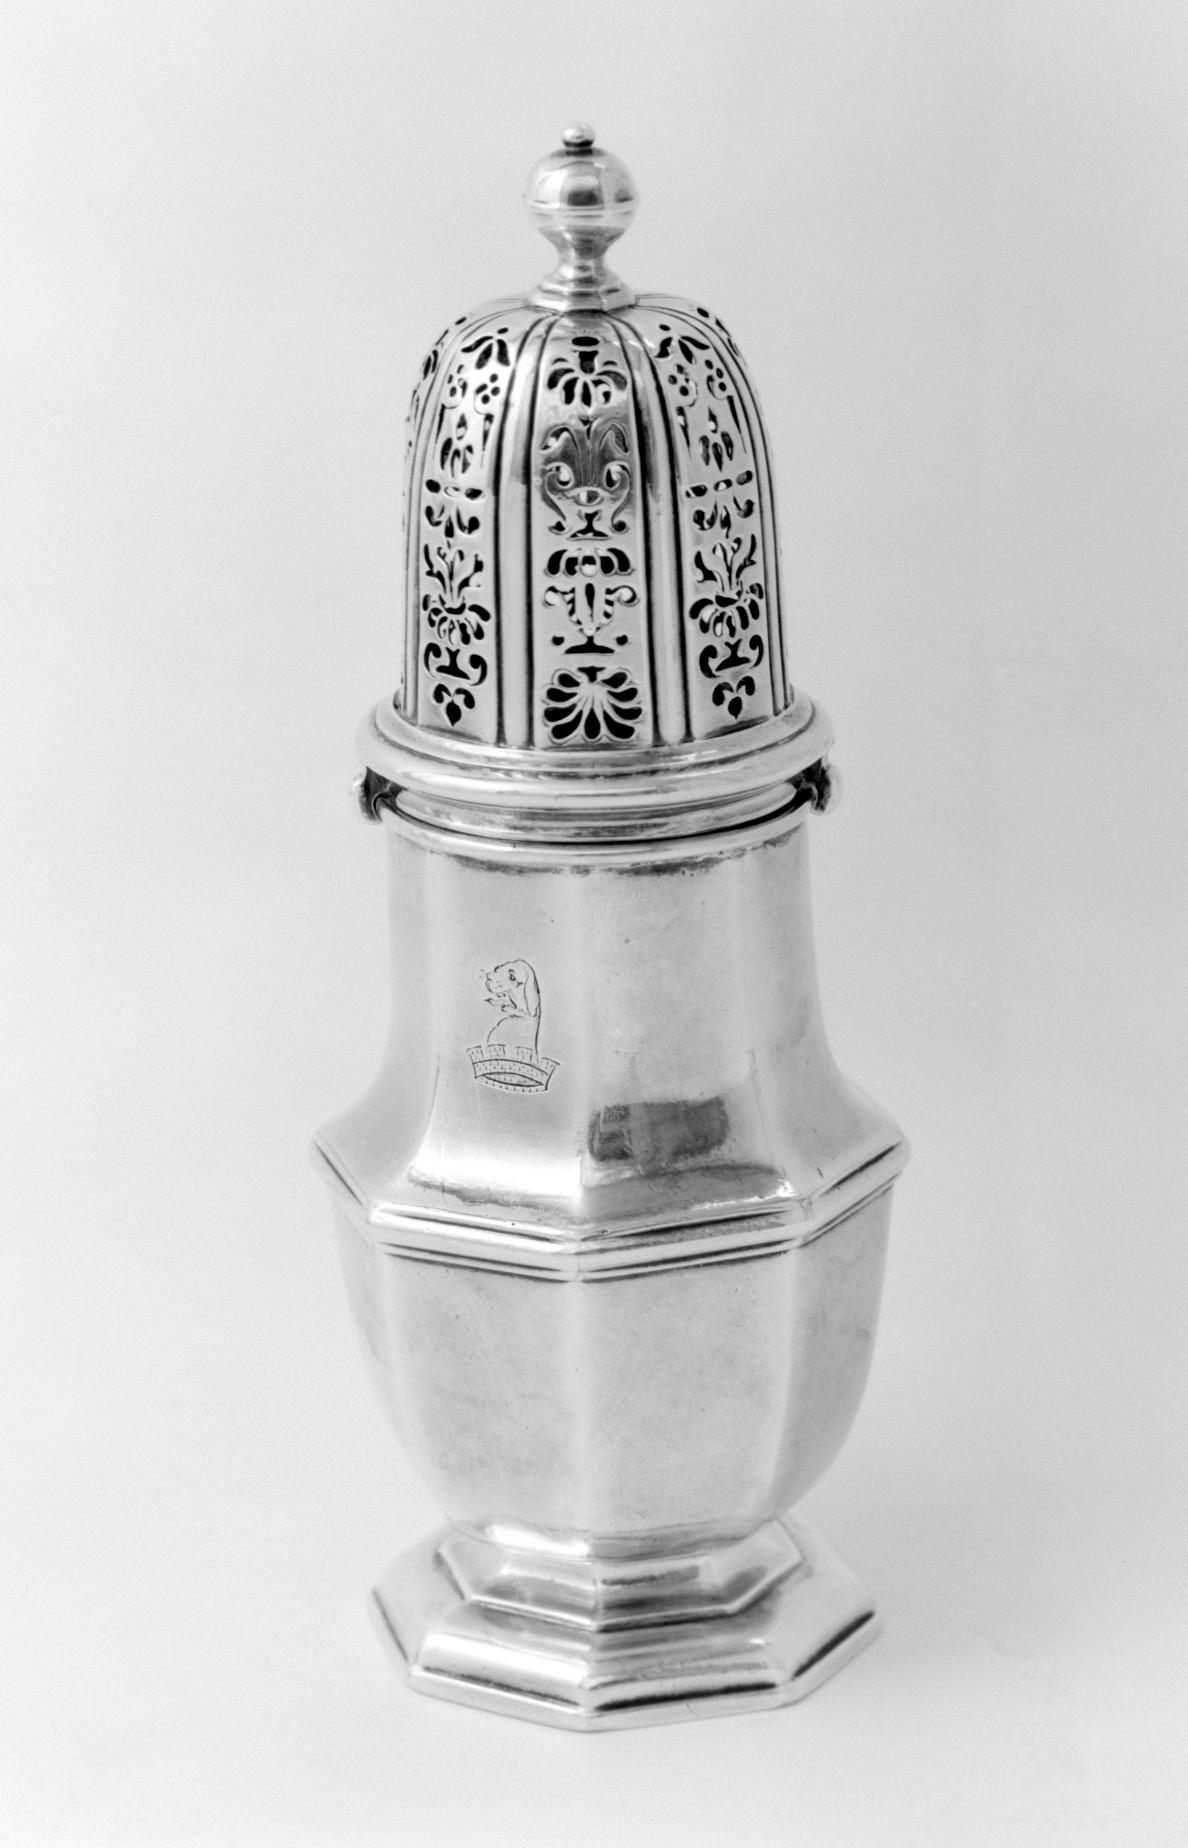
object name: caster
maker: john chartier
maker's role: maker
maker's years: 1697-1715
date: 1714-1715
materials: silver